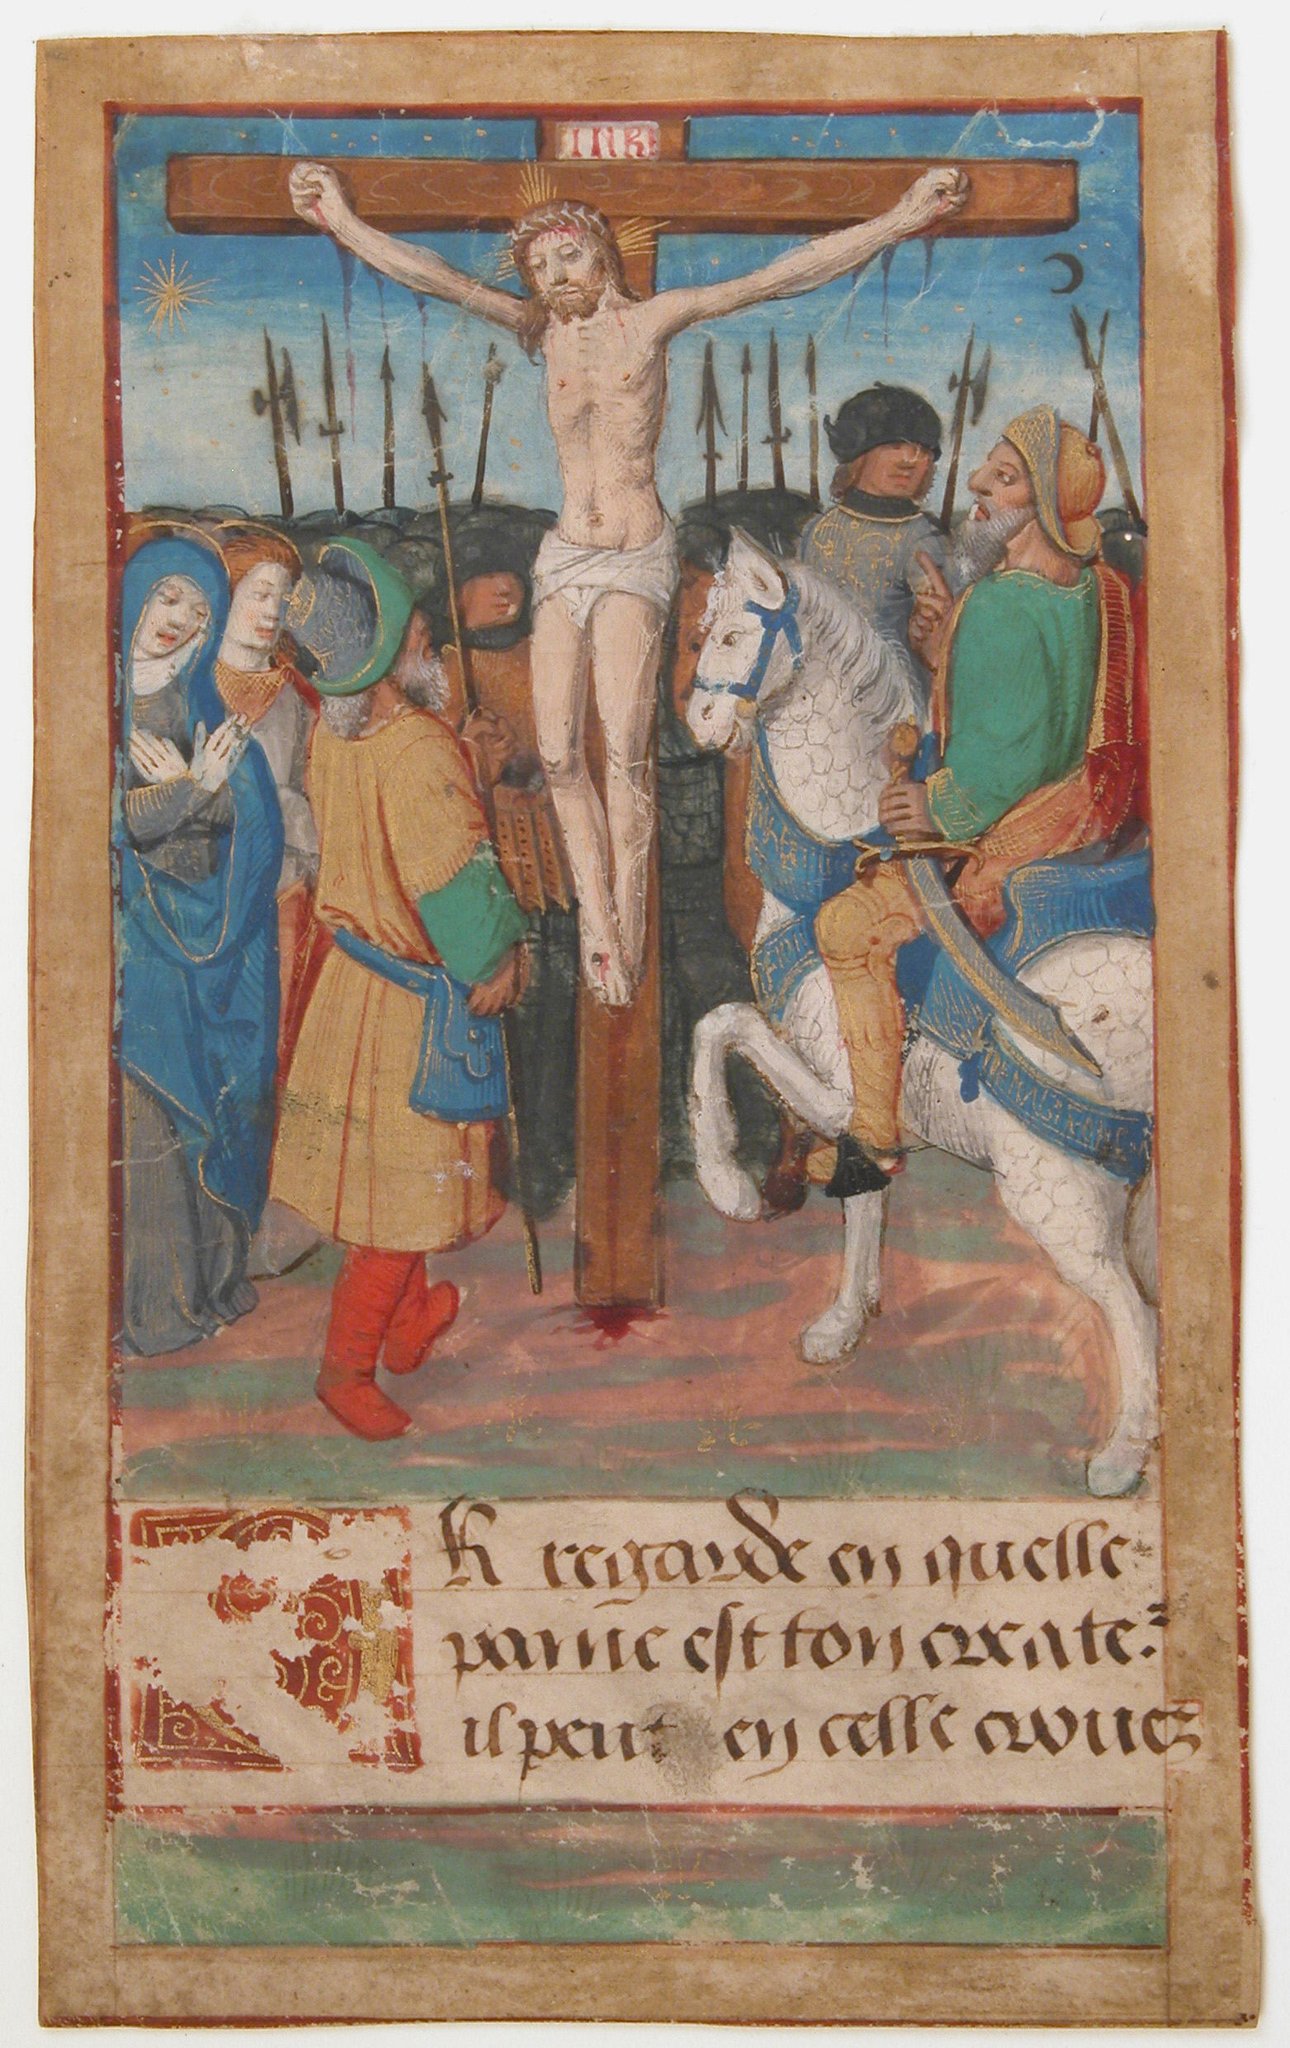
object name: book of hour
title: Manuscript Leaf with the Crucifixion, from a Book of Hours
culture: french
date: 1401-1500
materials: gold, ink, parchment, shell, paint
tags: horses,christ,crucifixion